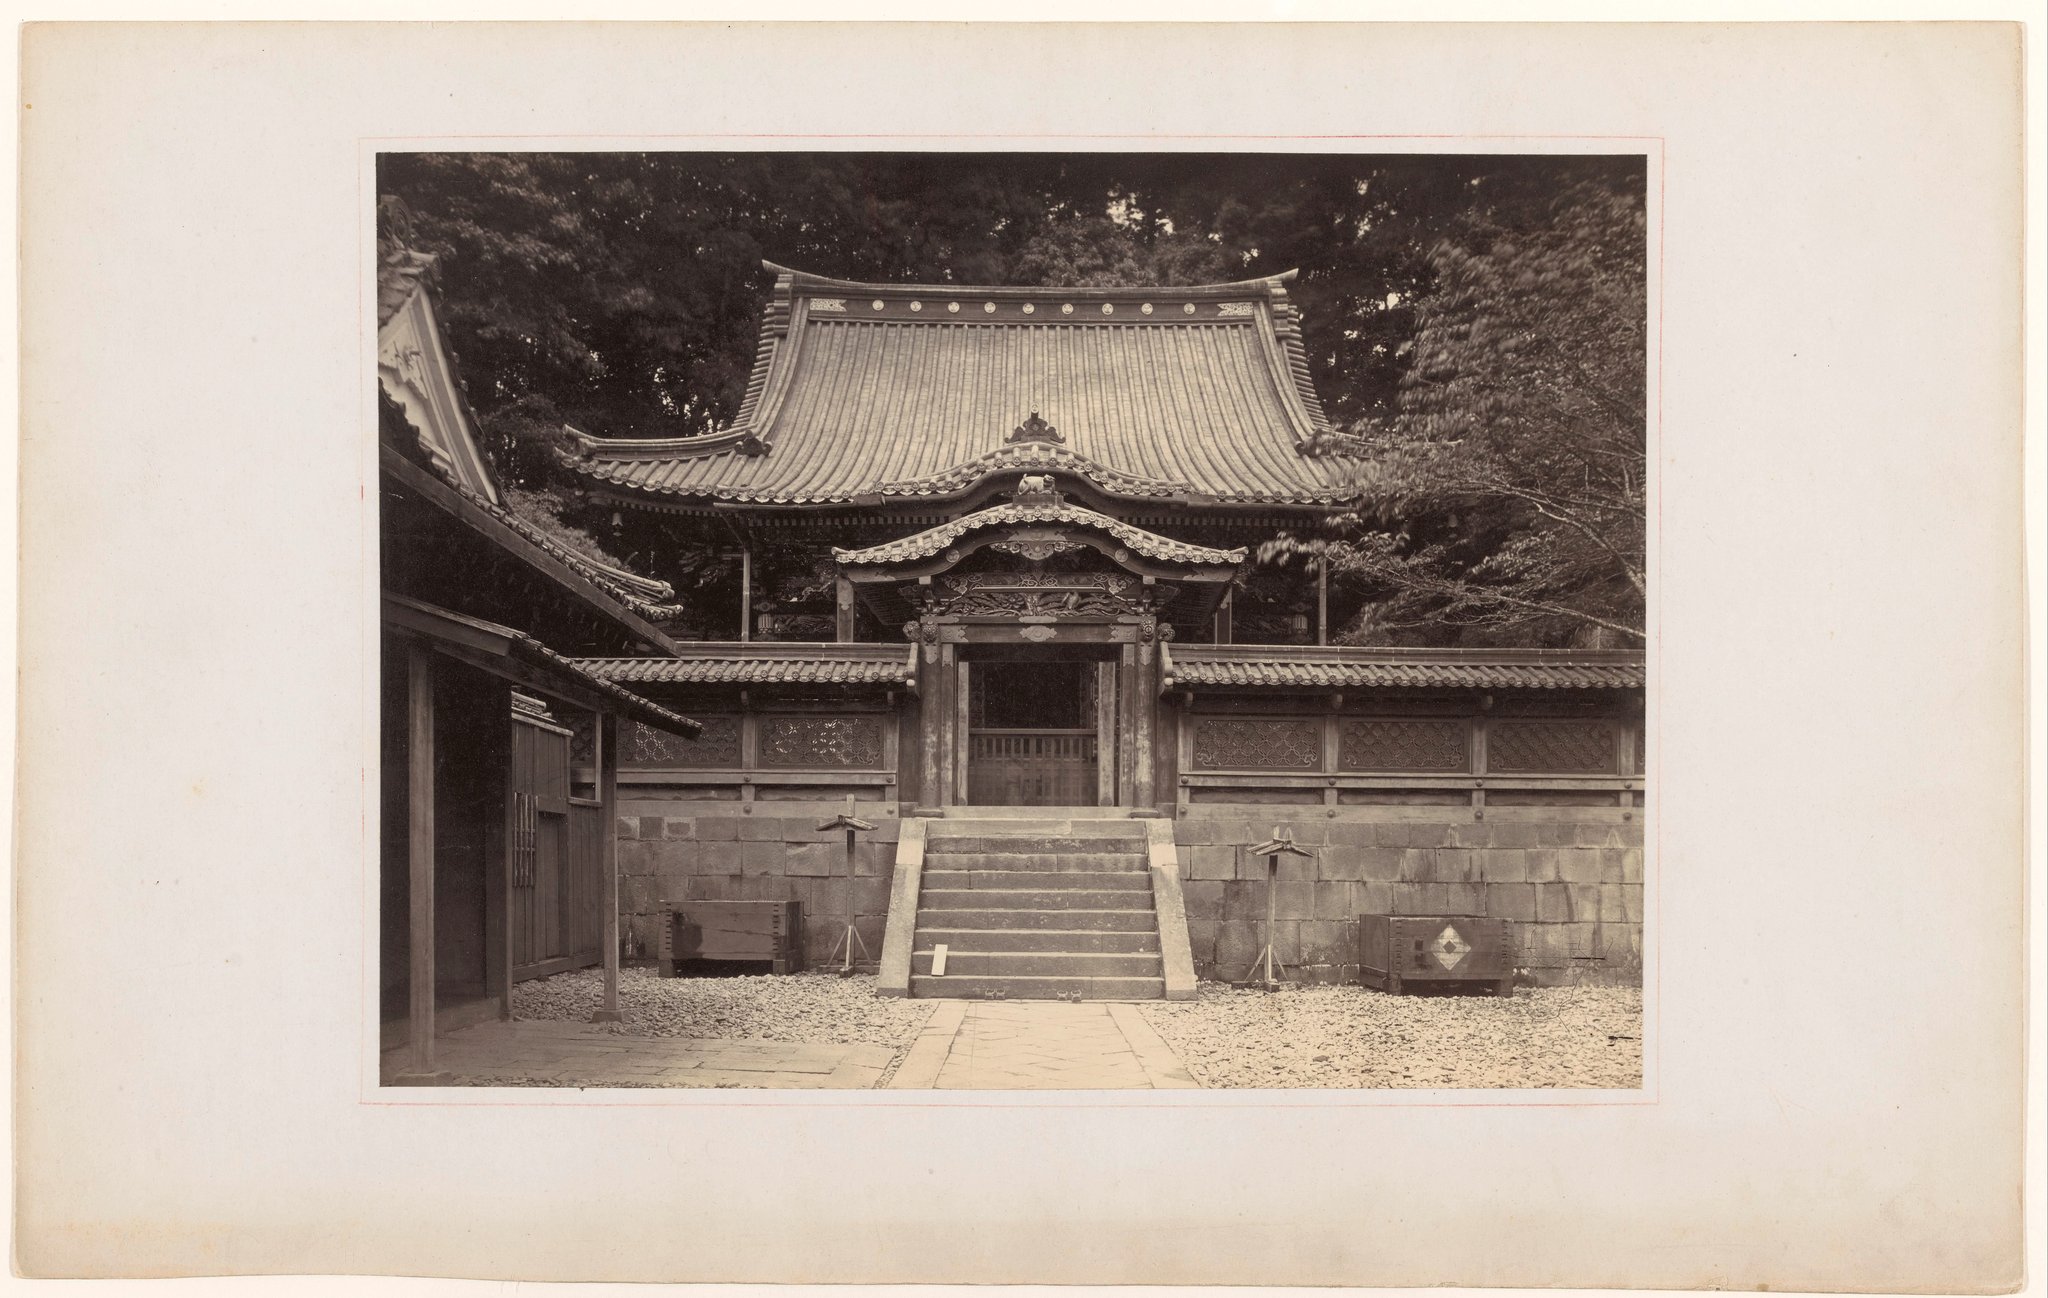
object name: photograph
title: Mausoleum van Oeyo bij het Zōjō-ji in Tokyo, Japan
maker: felice beato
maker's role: fotograaf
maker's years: 1825-1909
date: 1867-1868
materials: cardboard, paper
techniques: albumen print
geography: japan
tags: mausoleum